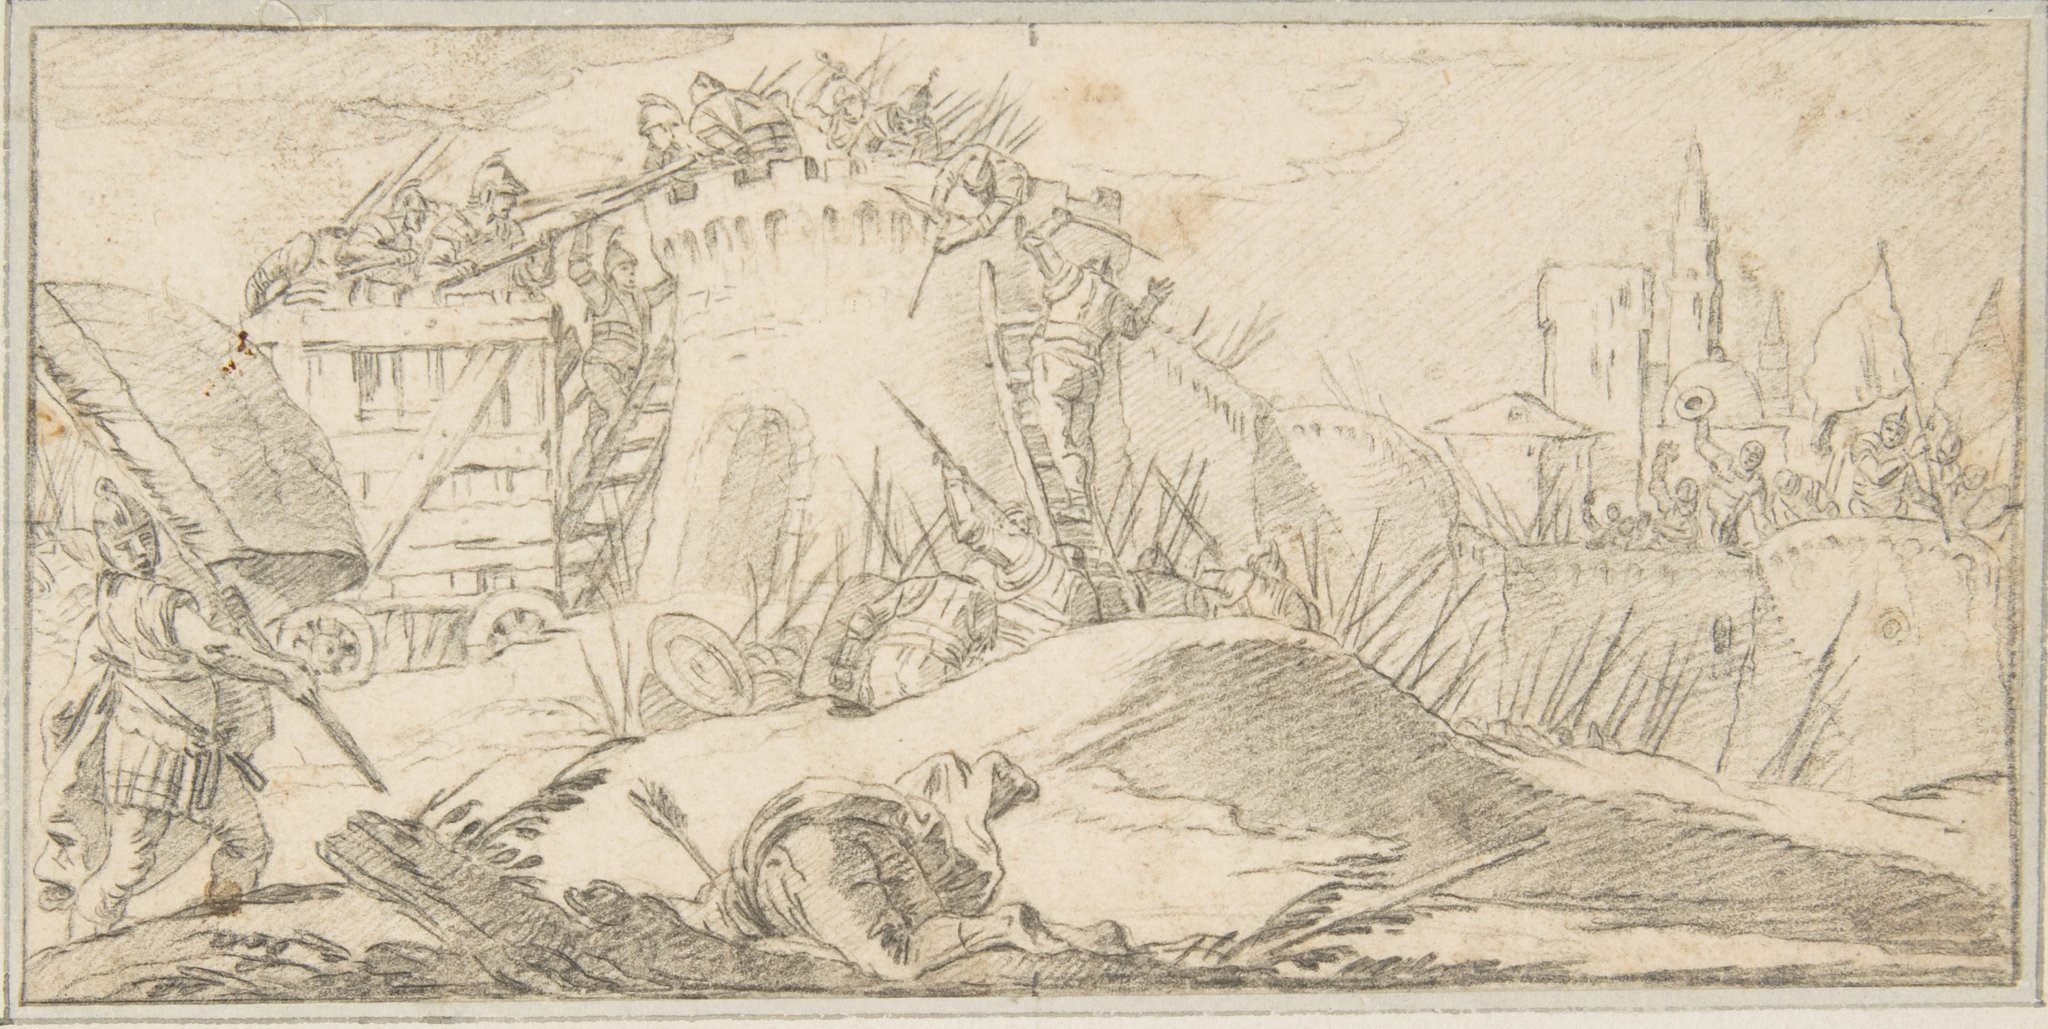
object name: drawing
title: Illustration for a Book: Attacks on the Walls of a City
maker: giovanni battista tiepolo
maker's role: artist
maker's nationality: italian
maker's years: 1696-1770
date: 1696-1770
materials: chalk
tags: cities,soldiers,flags